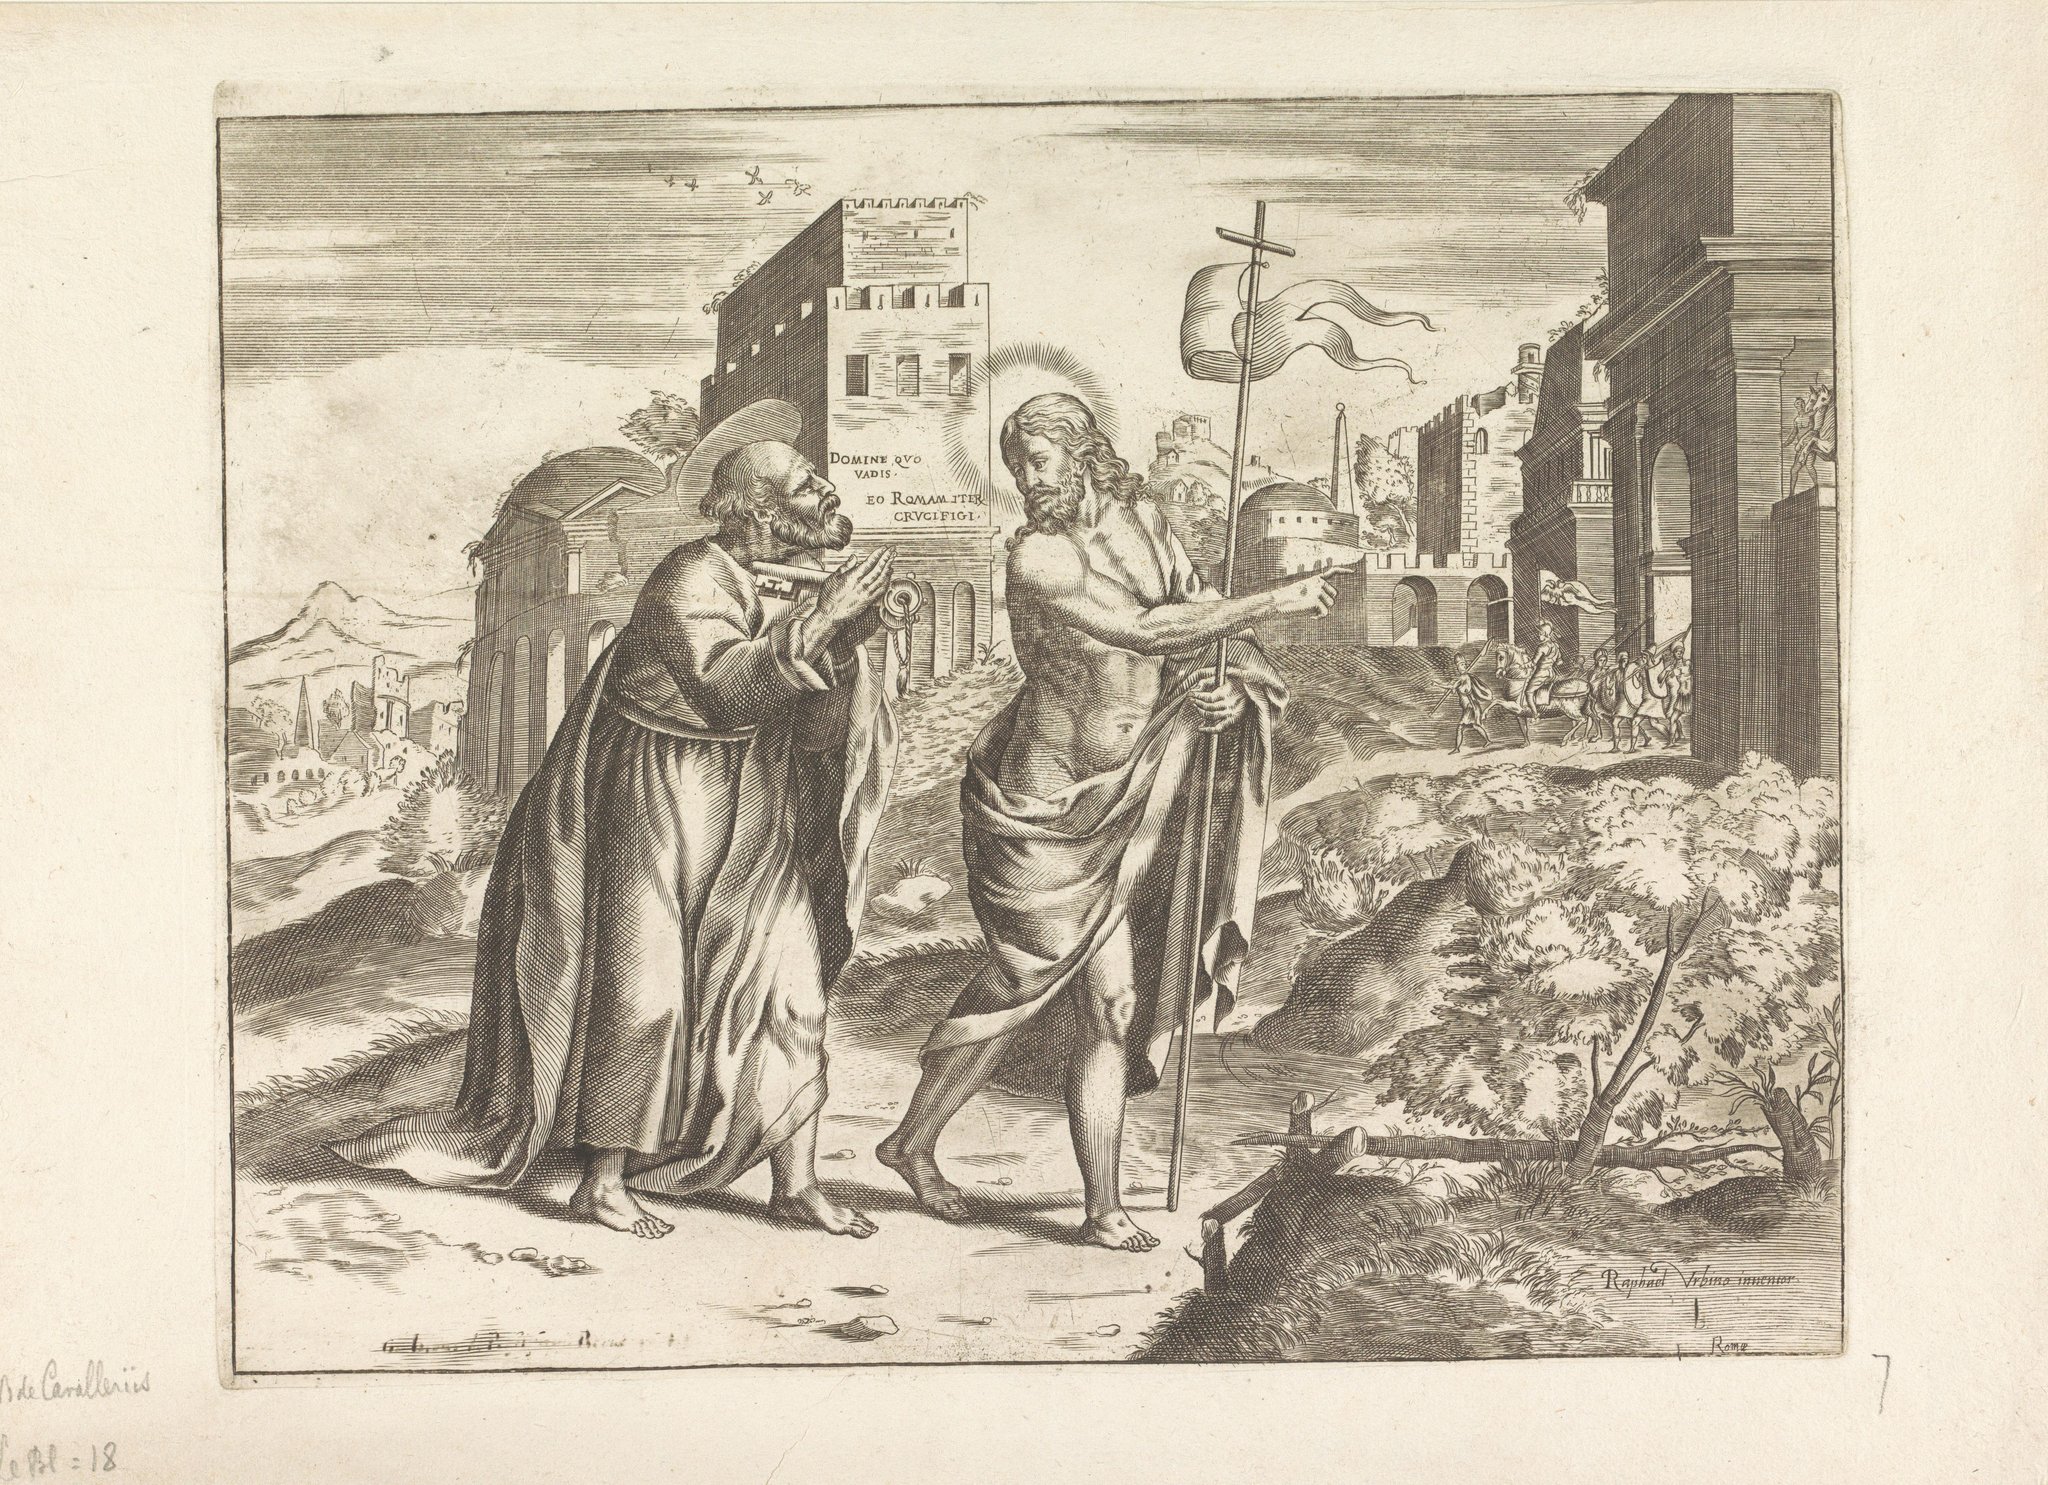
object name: print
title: Christus verschijnt aan Petrus bij de poort van Rome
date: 1569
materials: paper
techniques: engraving, etching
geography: italy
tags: peter tries to leave rome unnoticed: at the gate he meets christ, who usually carries the cross ('domine, quo vadis?'), rome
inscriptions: collector's mark: Lugt 2228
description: Christus verschijnt aan Petrus vlak buiten de stadspoort van Rome. Petrus vraagt aan Christus "Quo vadis, Domine?". Christus beantwoordt de vraag met "Eo Romam iterum crucifigi" (ik ga naar Rome om opnieuw gekruisigd te worden). Petrus houdt sleutels in zijn handen. Op de achtergrond rechts soldaten die de stad verlaten.